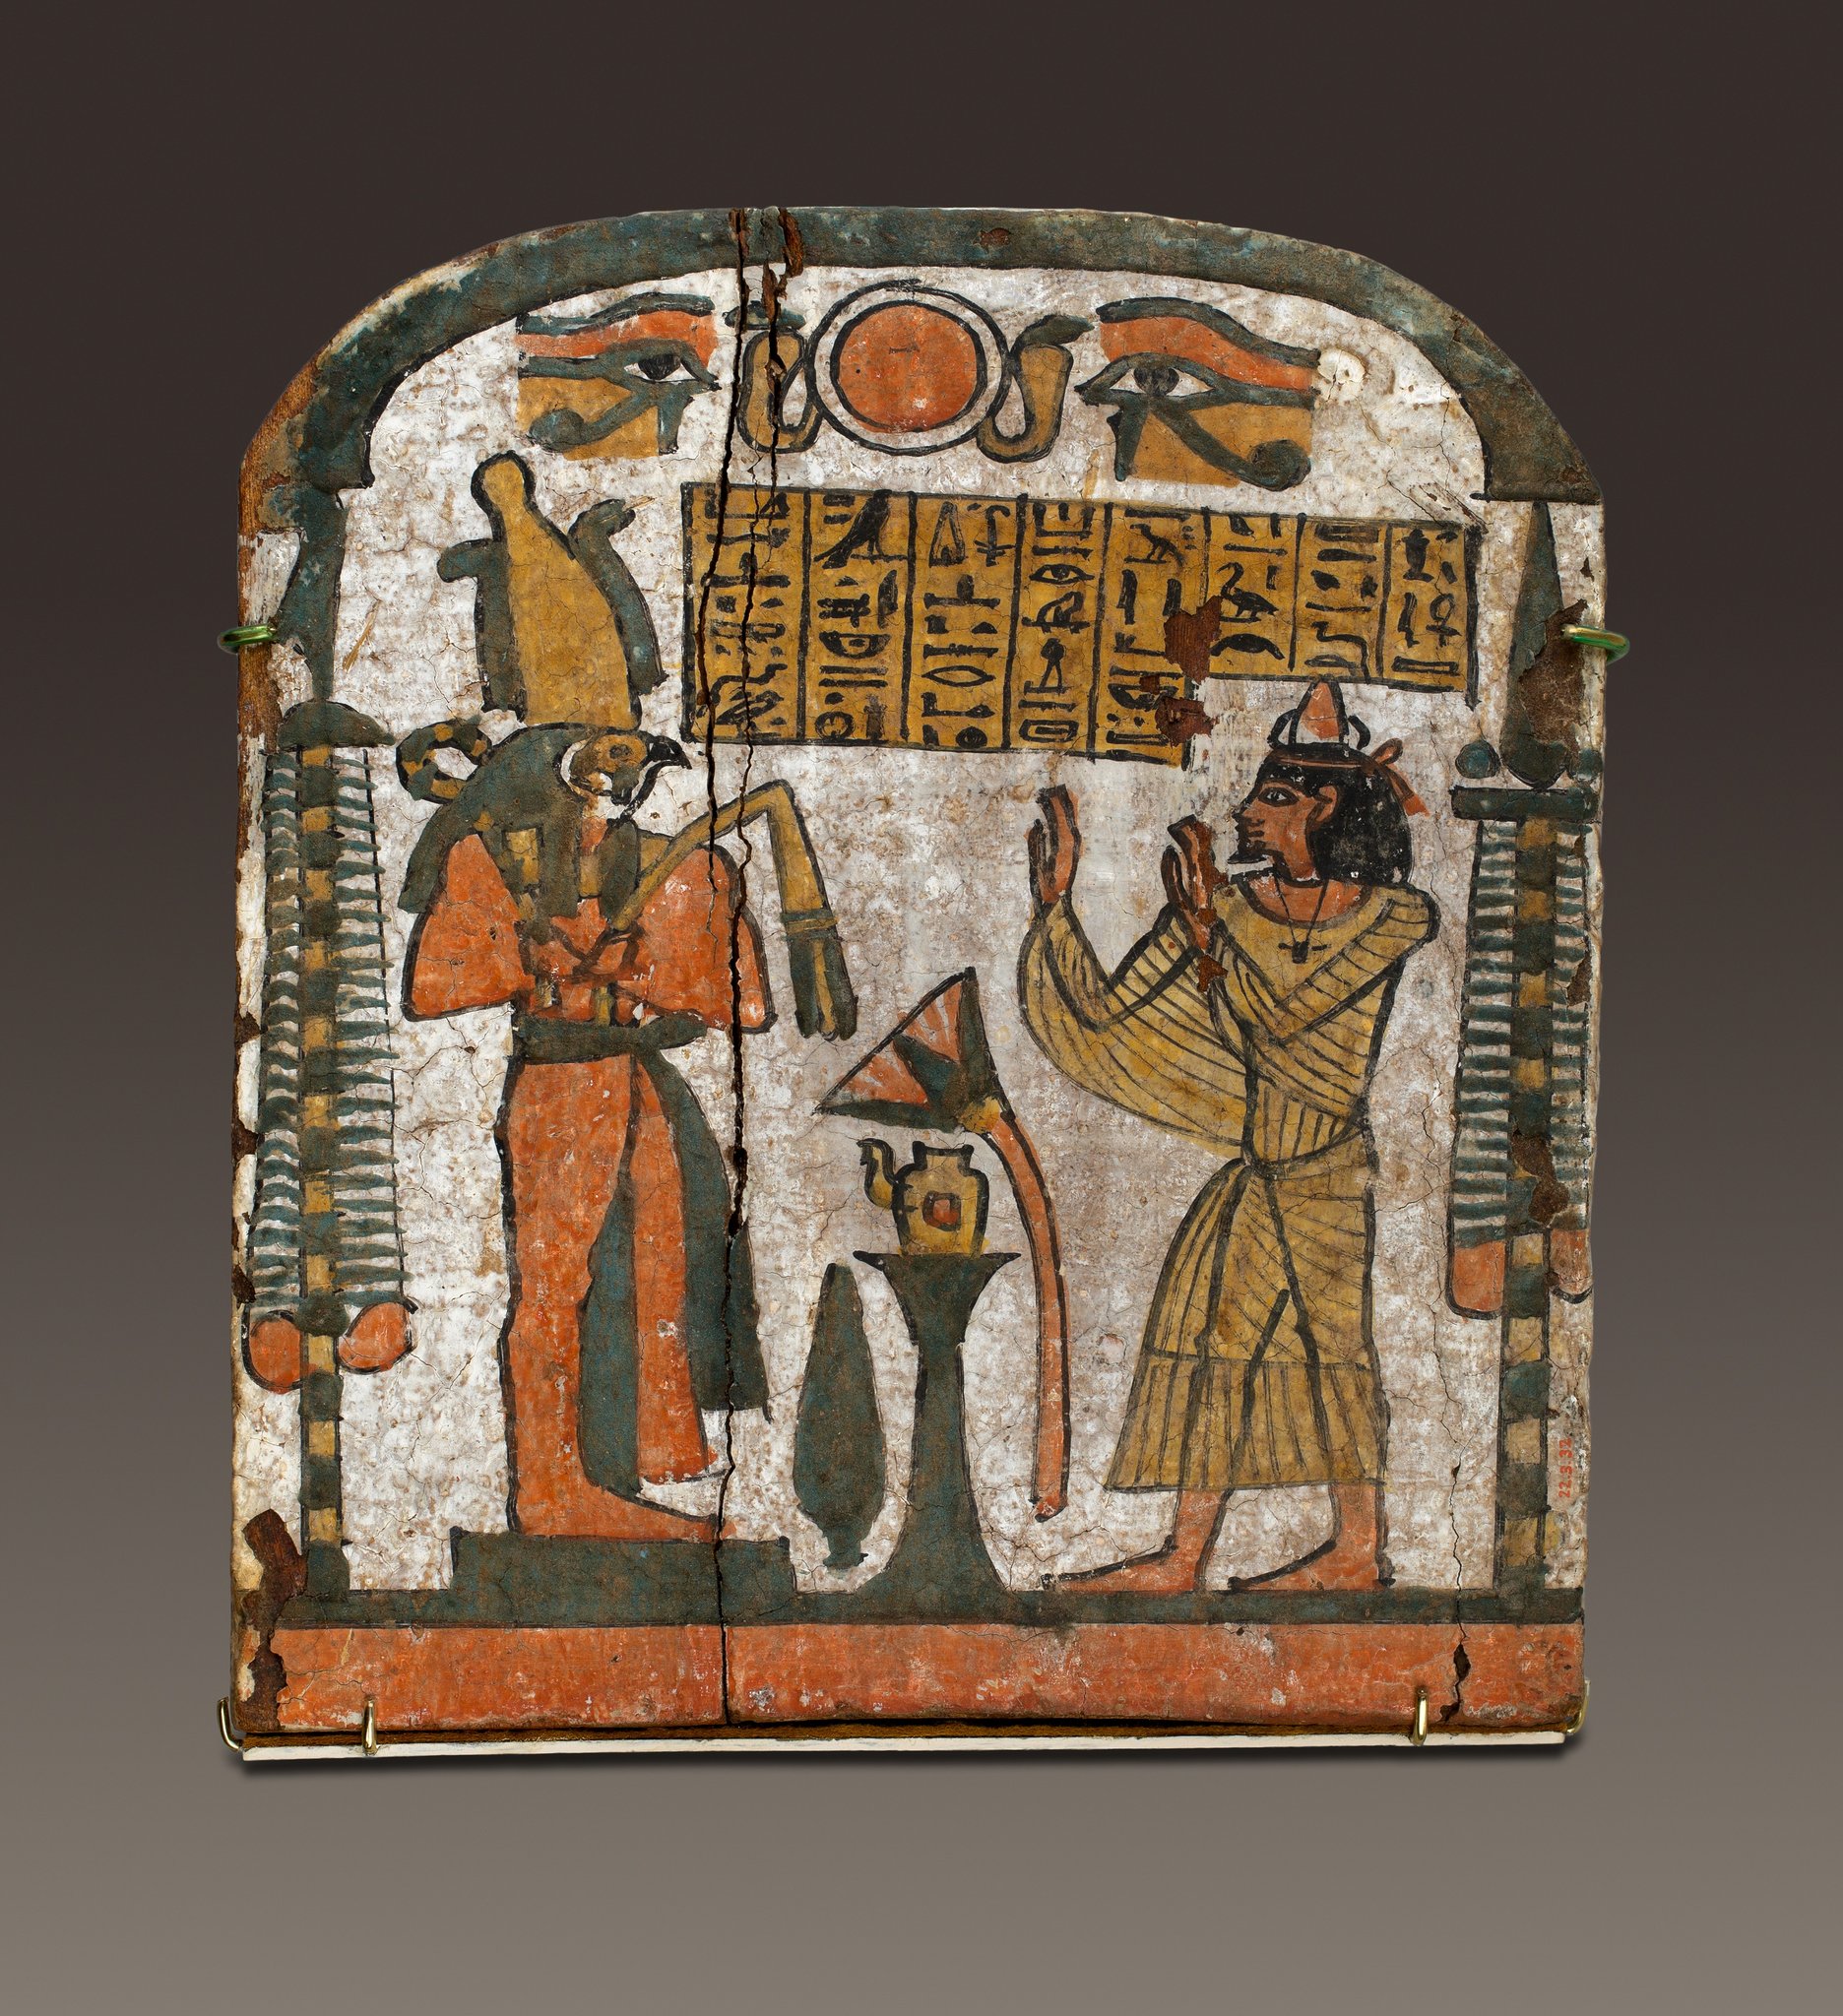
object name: stela, painted, inamennefnebu, nayefennebu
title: Stela of Inamennayefnebu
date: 825-712 BCE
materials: paint, paste, wood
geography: egypt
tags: hieroglyphs